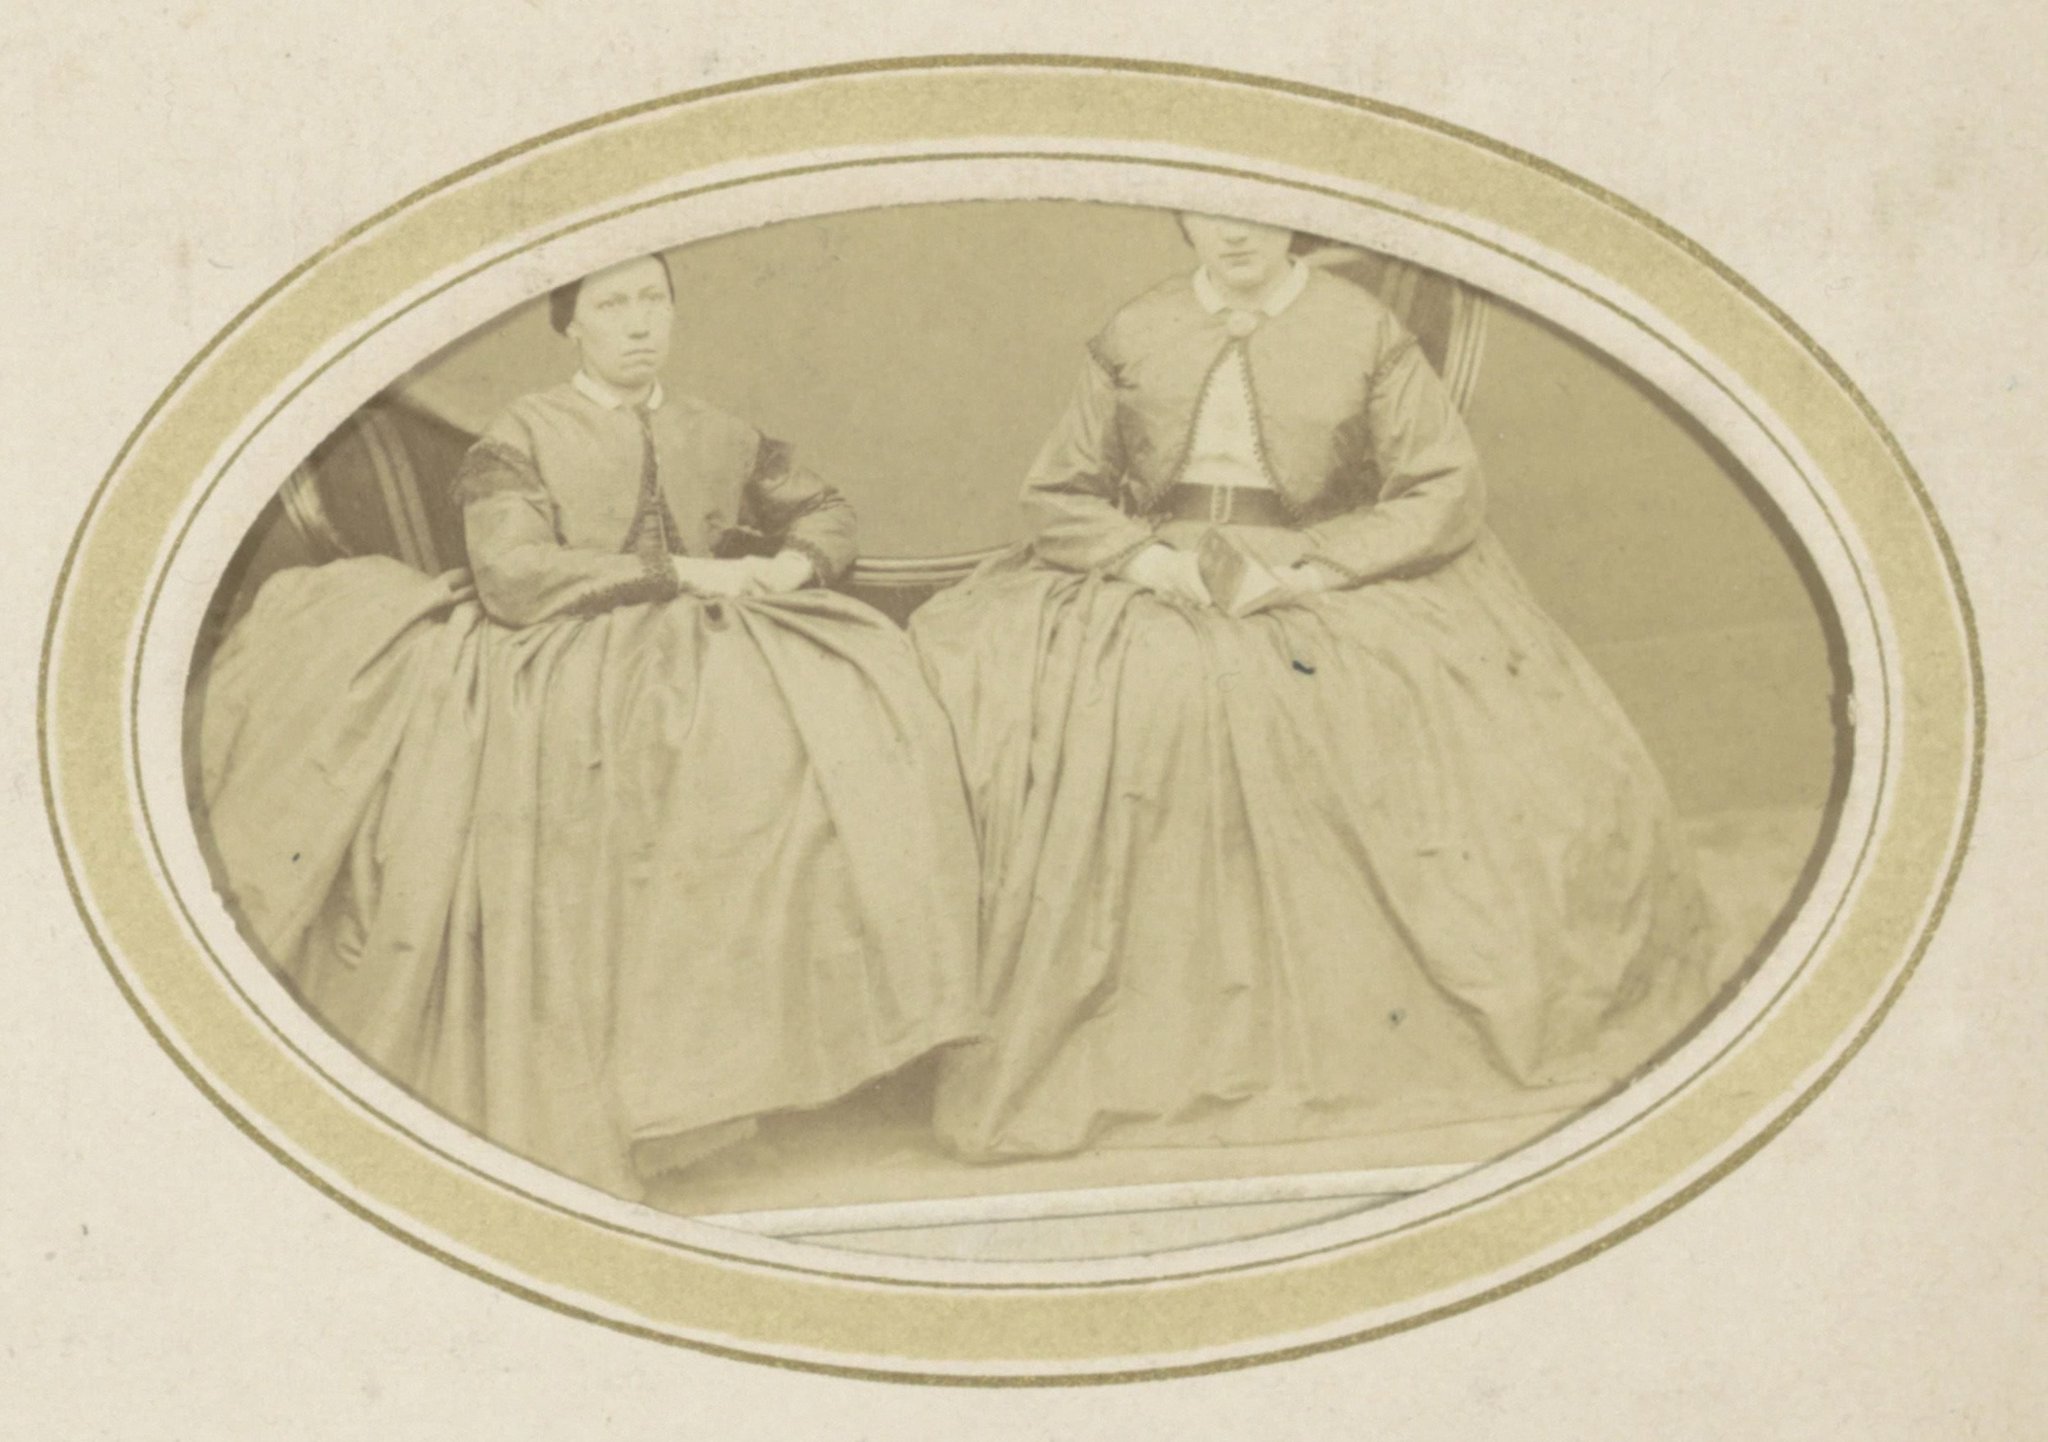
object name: carte de visite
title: Portret van twee vrouwen met een bolero en een wijde rok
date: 1868-1869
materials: cardboard, paper, photographic support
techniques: albumen print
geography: rotterdam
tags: studio requisites ~ photographer, historical persons, styles of hairdress - aa - ~ women, clothing for the upper part of the body, skirt, ear-rings, rotterdam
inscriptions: address: ‘Nieuwe Veemarkt 14-341 Rotterdam’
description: Onderdeel van Fotoalbum van een Nederlandse familie met 168 cartes-de-visite en kabinetfoto's.